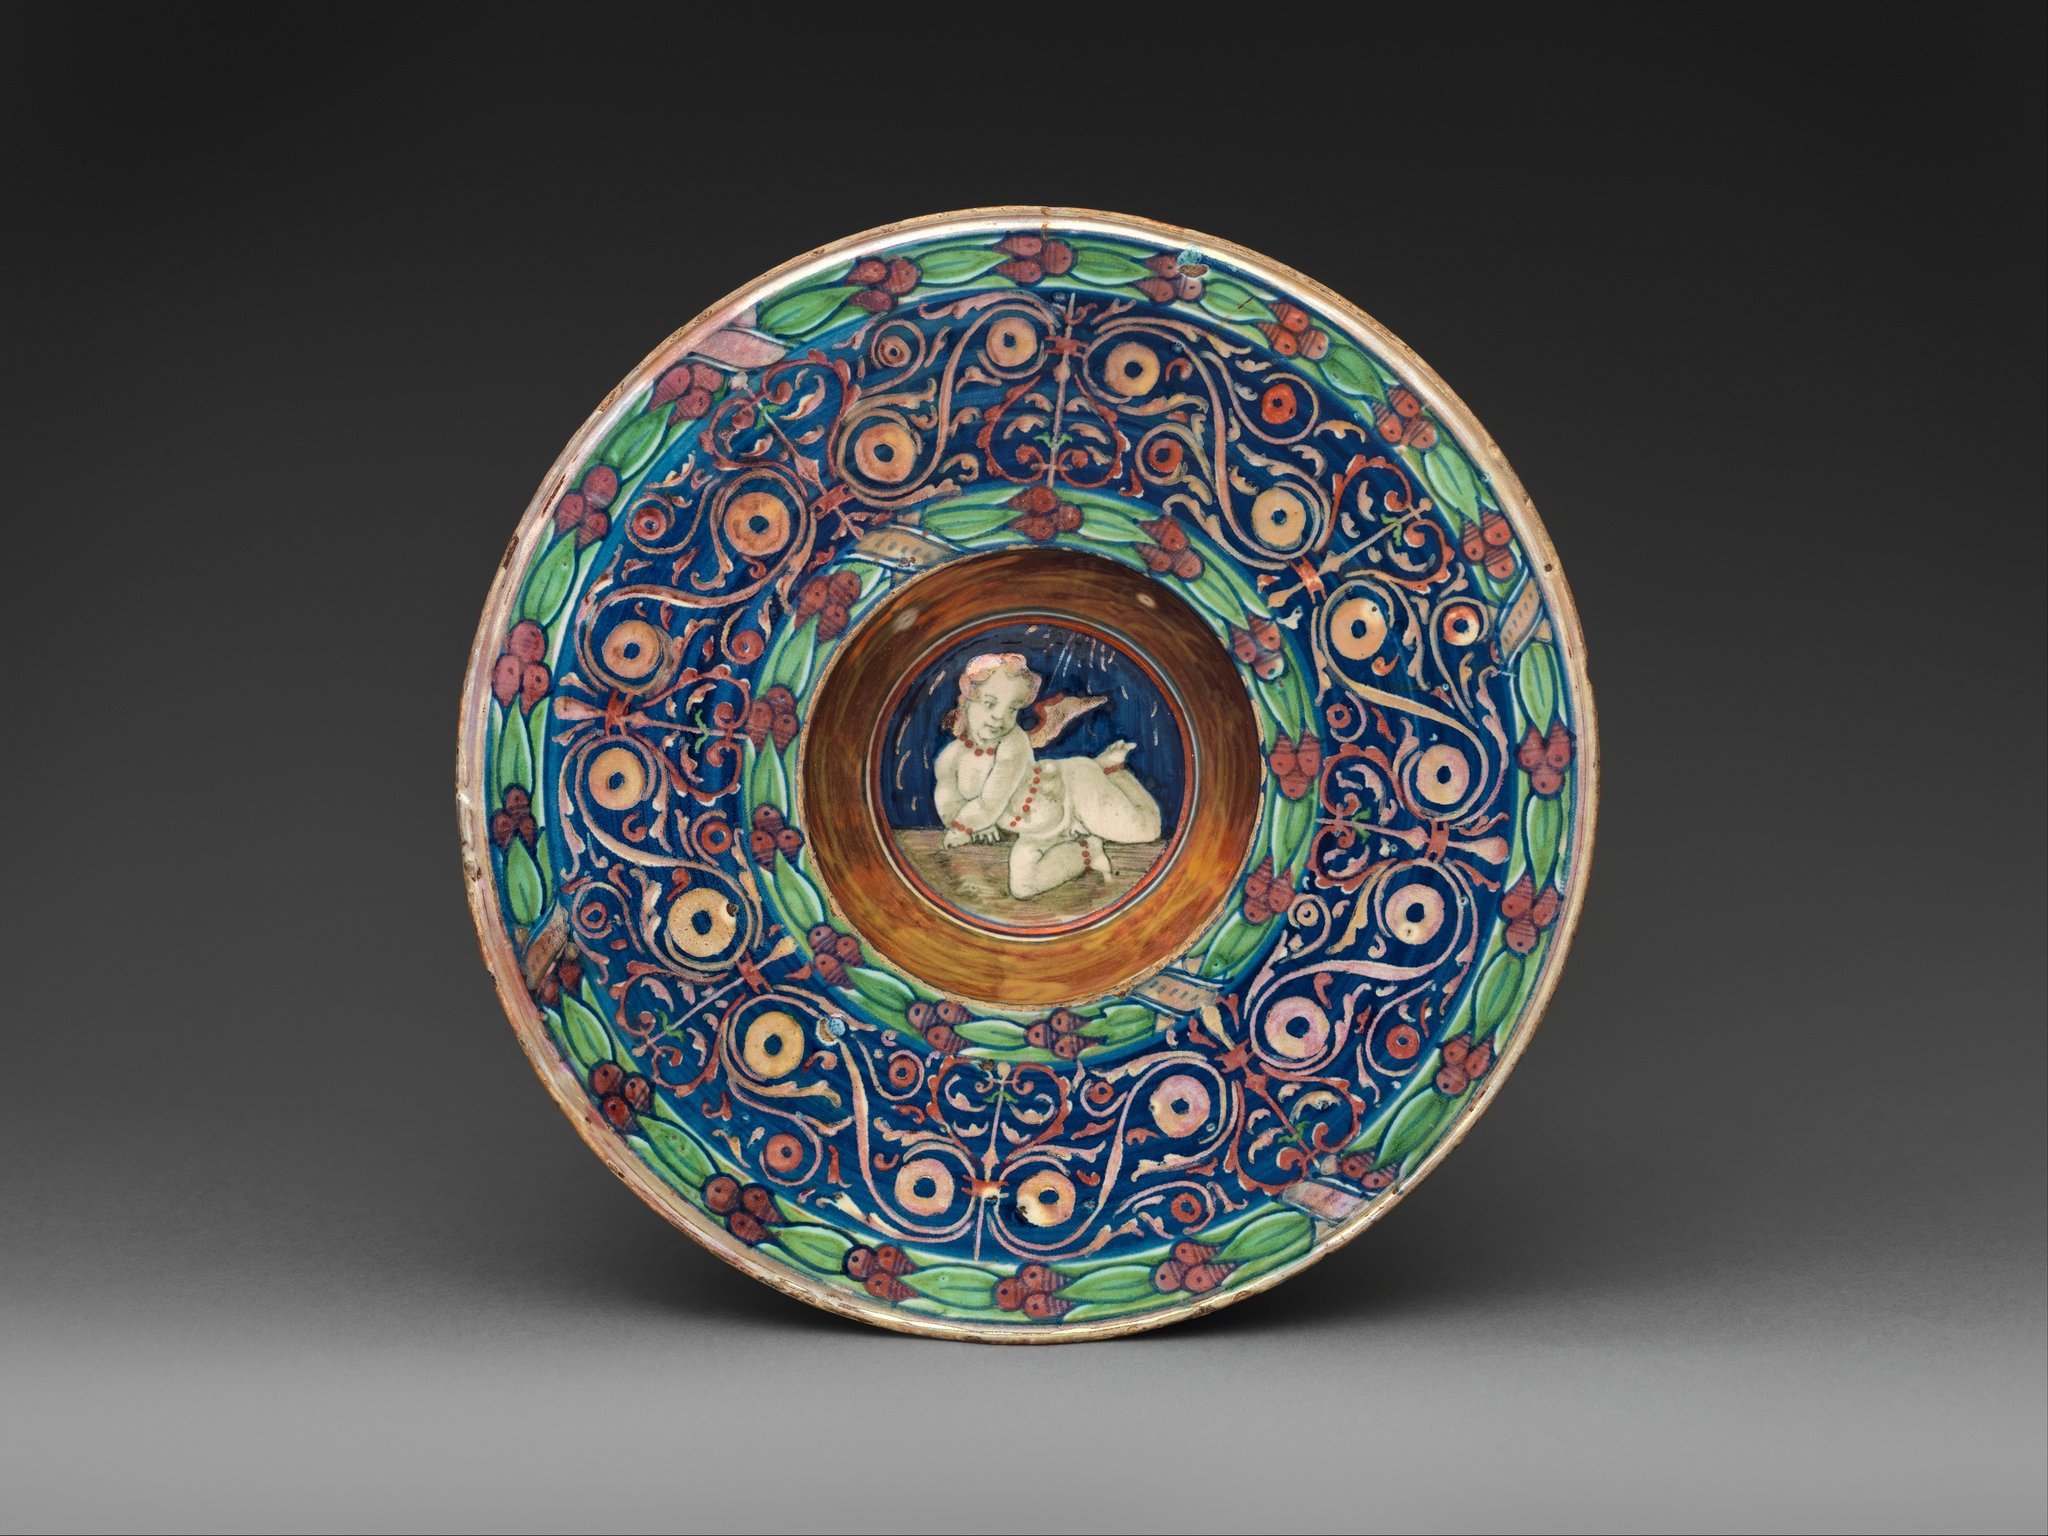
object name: bowl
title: Wide-rimmed bowl with winged putto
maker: maestro giorgio andreoli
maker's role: decorator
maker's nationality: italian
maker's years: 1500-1550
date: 1526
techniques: maiolica, glazing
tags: putti